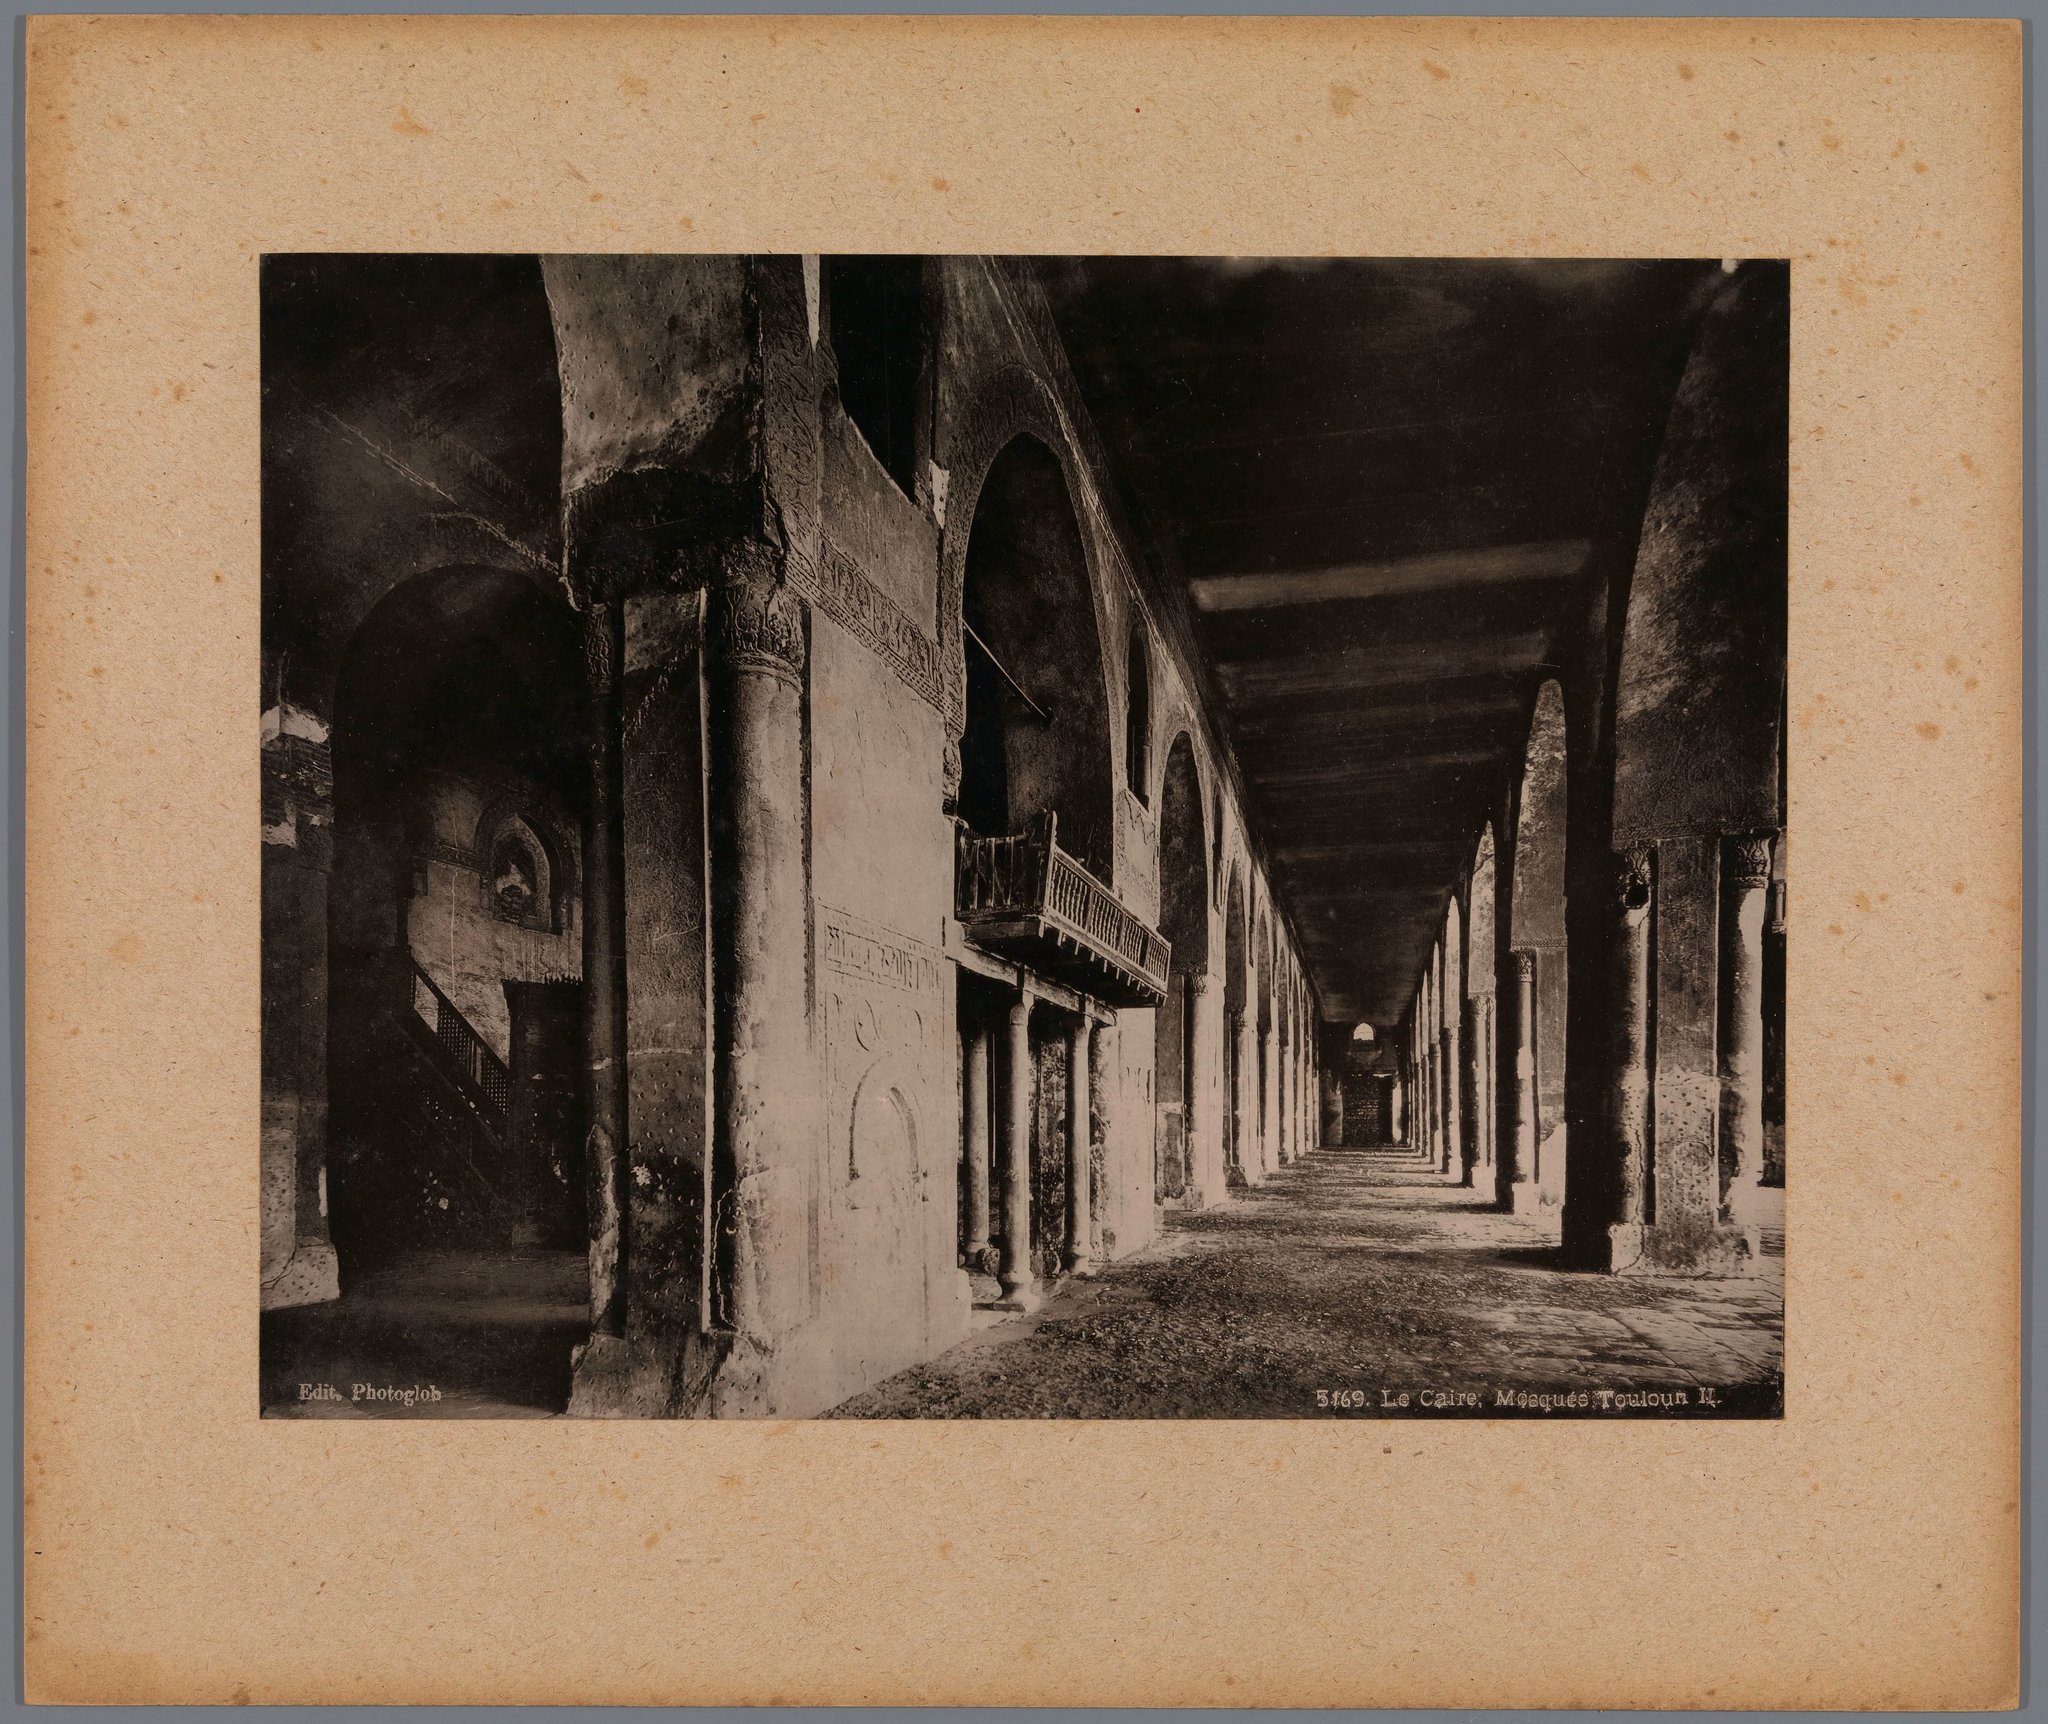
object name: photograph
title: Le Caire. Mosquée Toulon II.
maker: Anonymous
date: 1875-1900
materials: cardboard, paper, ink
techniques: photograph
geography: ibn toeloenmoskee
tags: flat decoration ~ applied arts (+ islamic art), temple, shrine ~ islam, mohammedanism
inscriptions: collector's mark: ‘INSTITUUT VOOR KUNST-NIJVERHEIDSONDERWIJS GABRIËL METSUSTRAAT No. 16 AMSTERDAM’, collector's mark: ‘KUNSTNIJVERHEIDSCHOOL QUELLINUS AMSTERDAM FRANS HALSSTRAAT 14.’, number: ‘5169.’